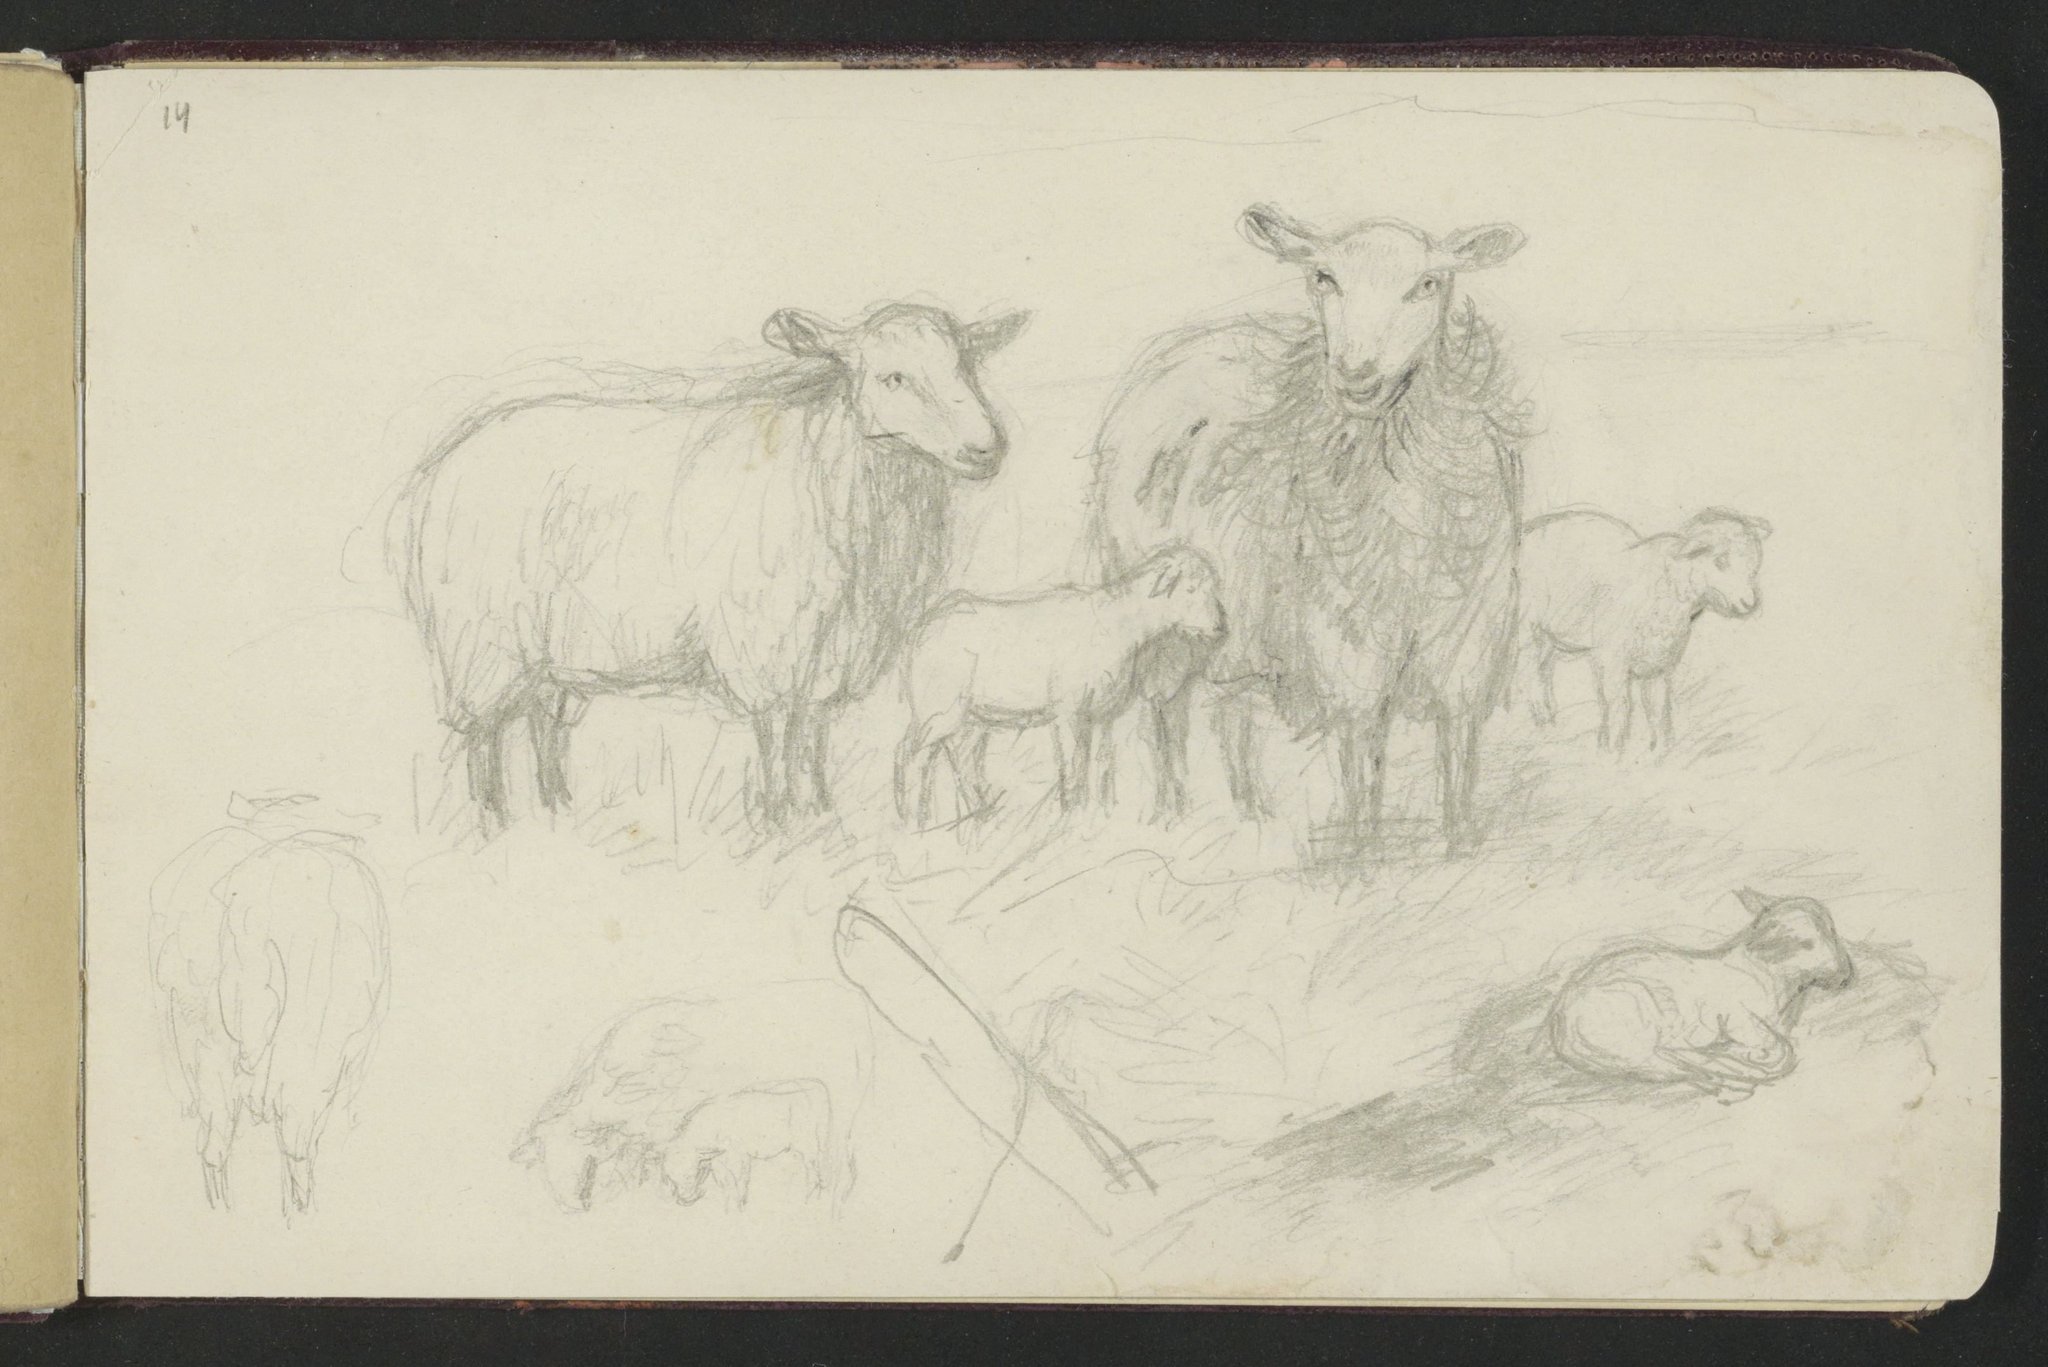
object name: sketchbook leaf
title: Schapen in een wei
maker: jozef israëls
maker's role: draughtsman, painter, print maker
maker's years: 1824-1911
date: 1885-1911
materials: paper, pencil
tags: meadow, pasture, sheep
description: Blad 14 recto uit een schetsboek met 26 bladen.